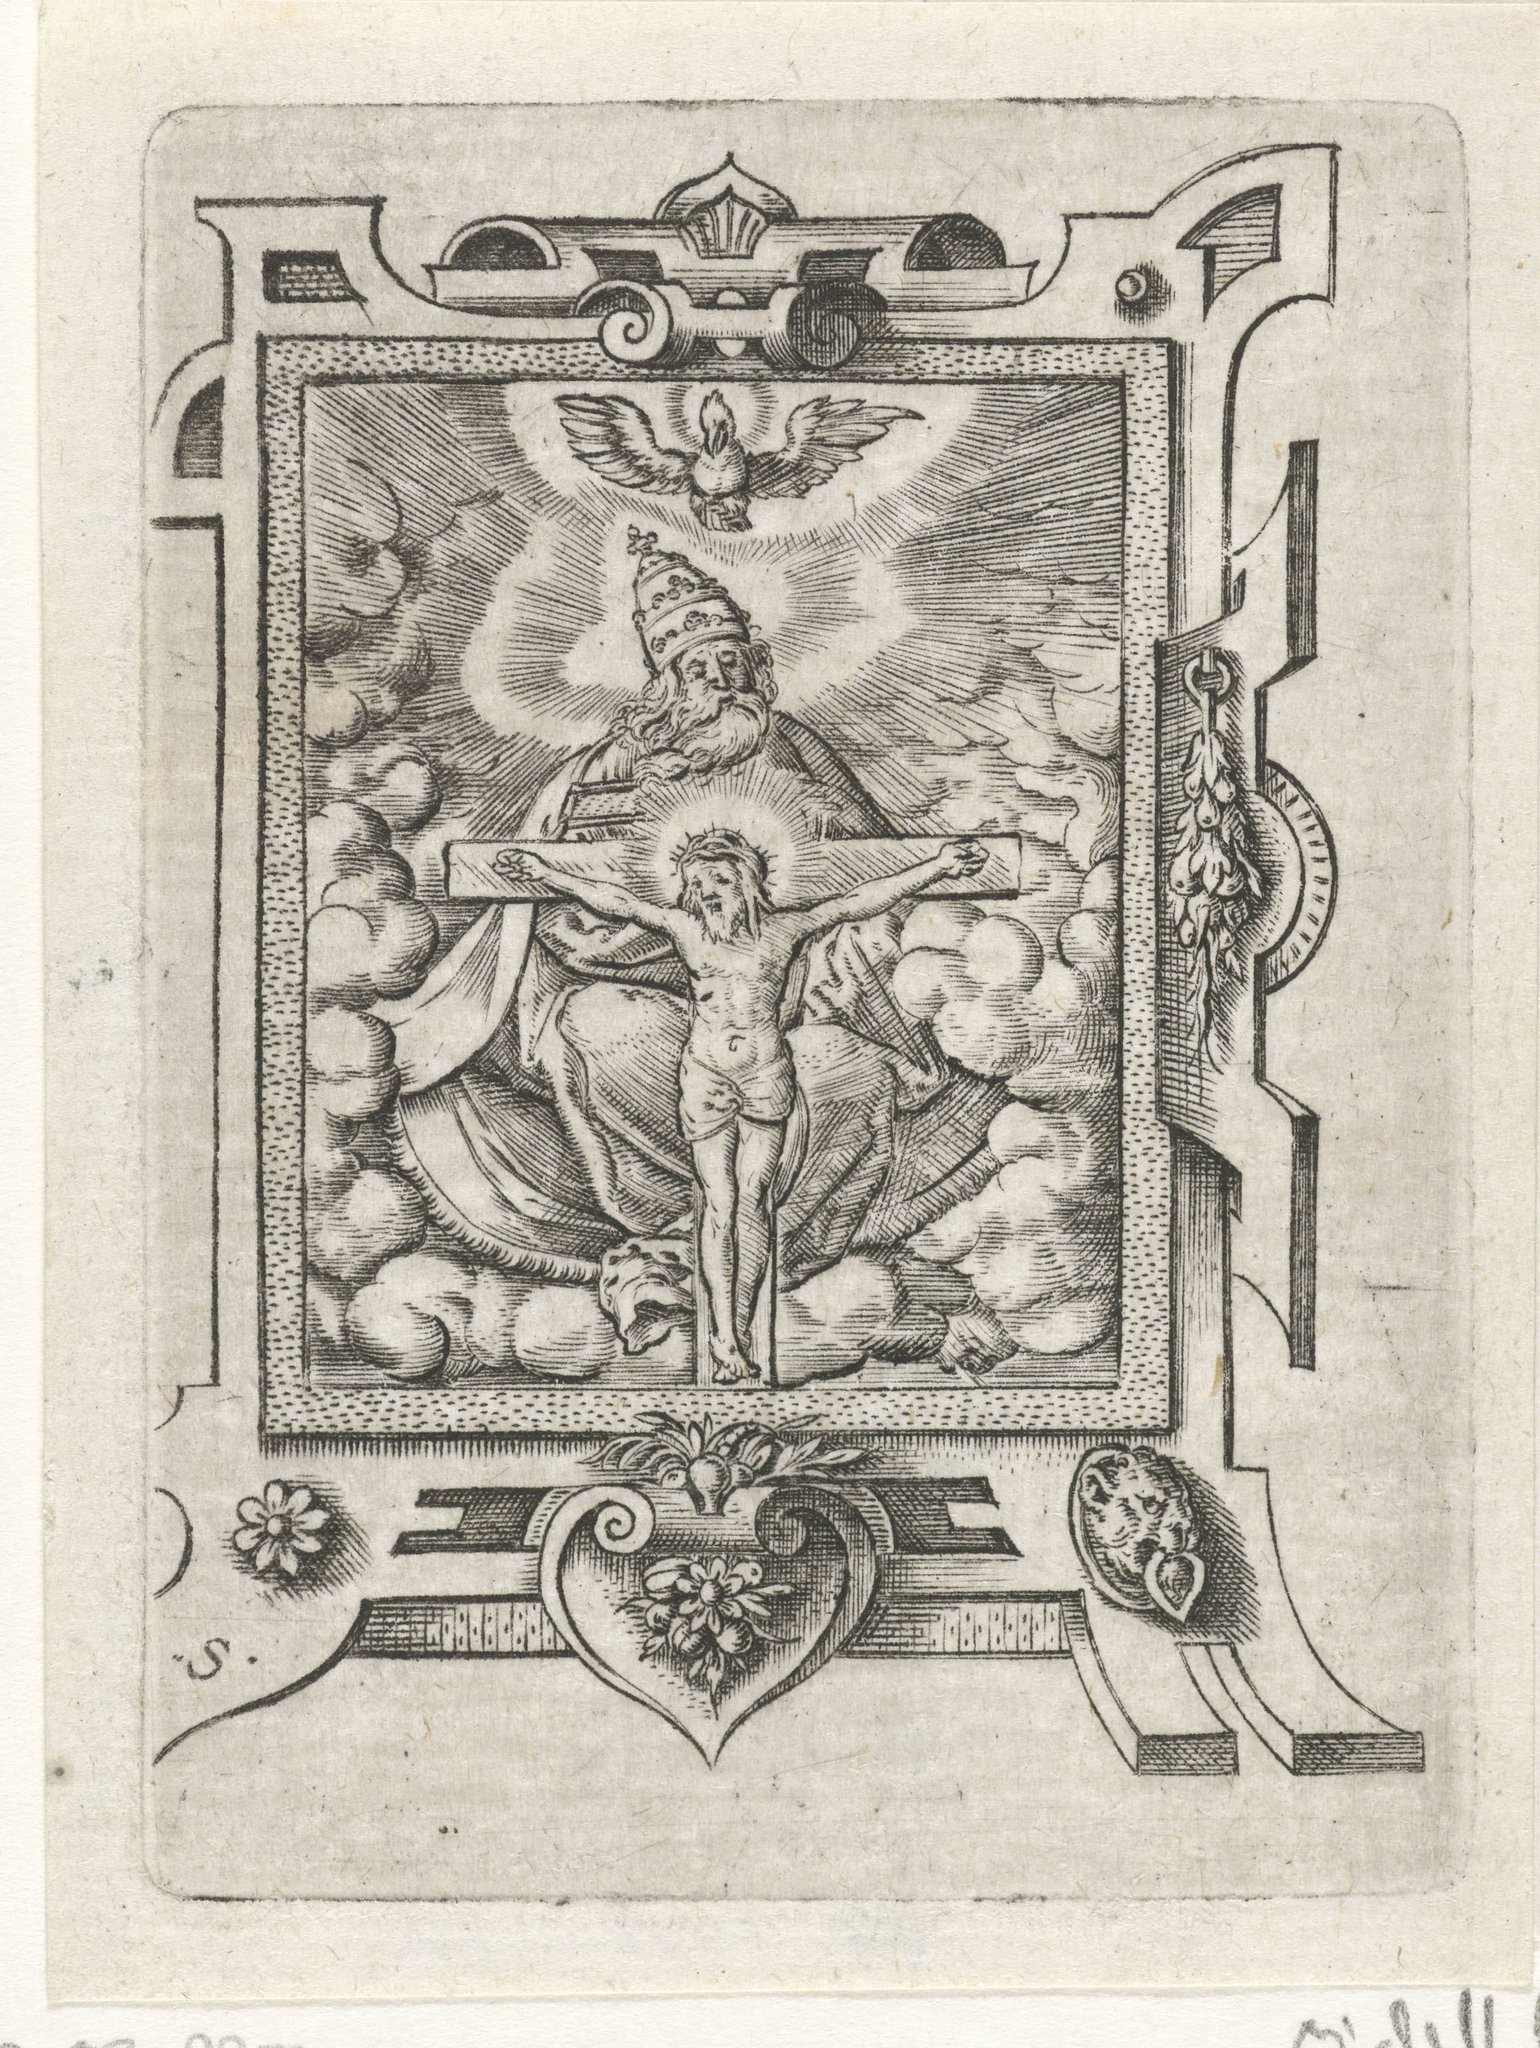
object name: print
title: De Drieëenheid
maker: virgilius solis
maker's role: draughtsman, print maker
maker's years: 1514-1562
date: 1524-1562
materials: paper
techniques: engraving